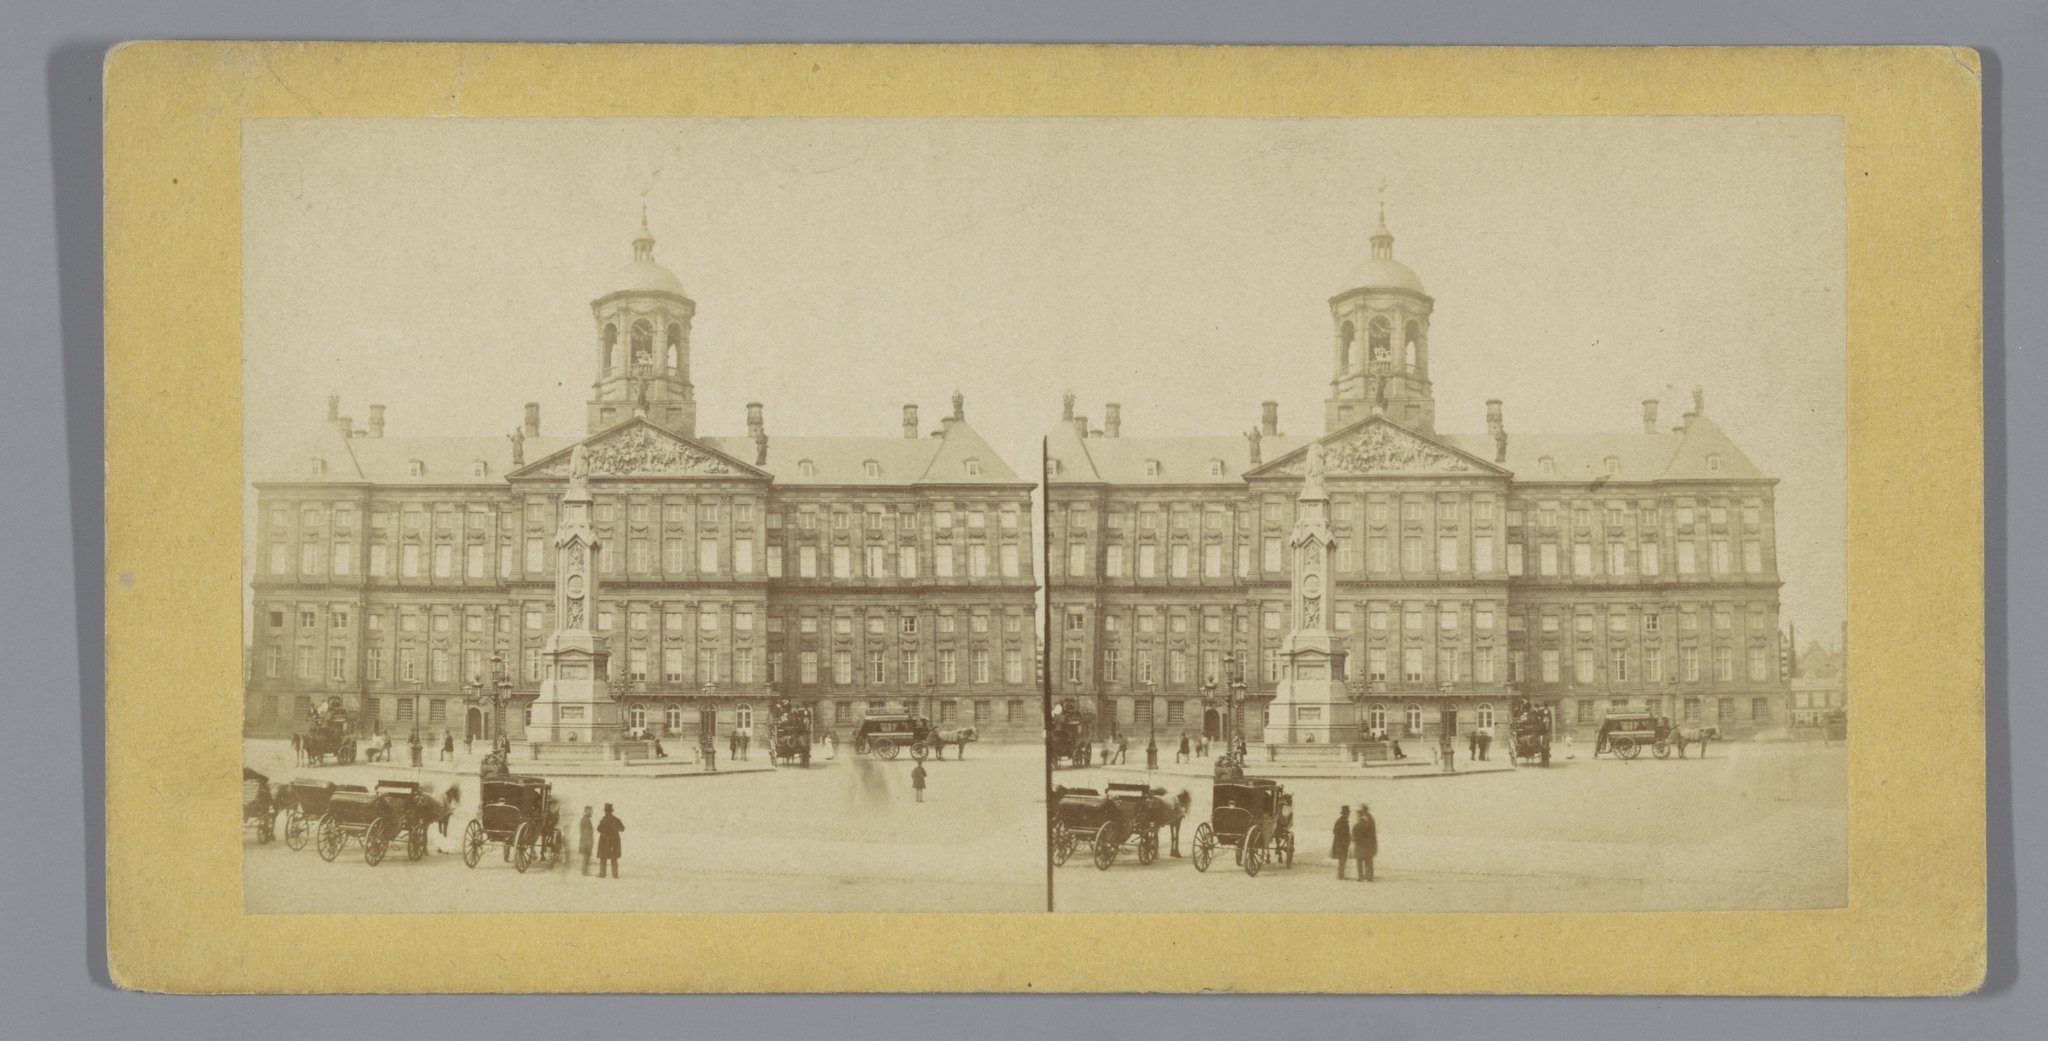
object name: stereograph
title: Le Dam, Amsterdam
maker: Anonymous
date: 1856-1870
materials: cardboard, paper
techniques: albumen print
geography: amsterdam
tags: square, place, circus, etc., royal palace of amsterdam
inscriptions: retailer's mark: ‘C.P. Staalman/ Amsterdam’